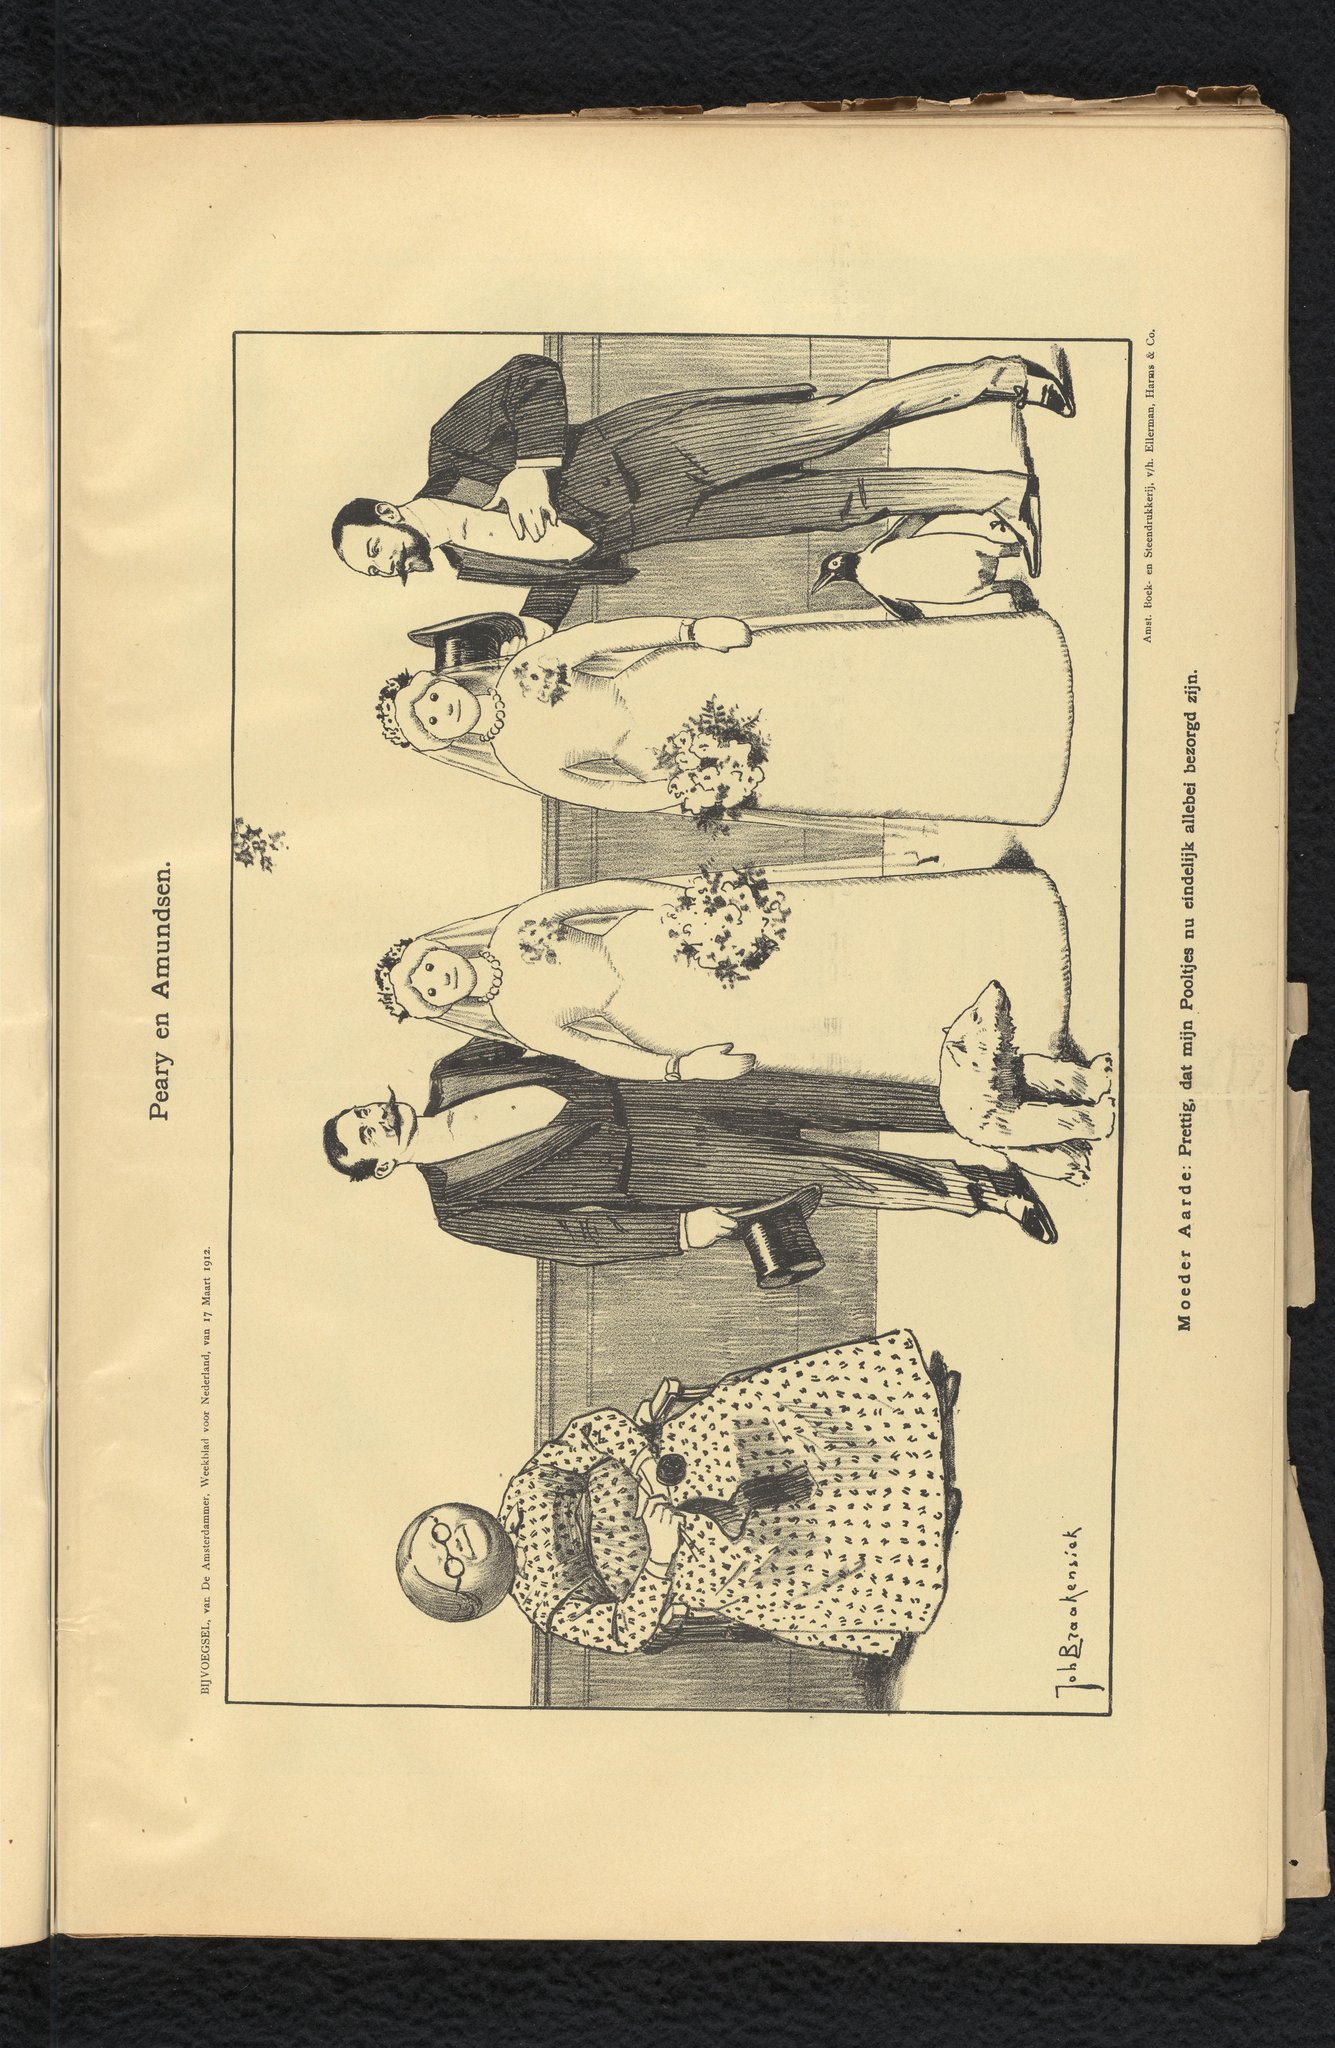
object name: cartoon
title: Peary en Amundsen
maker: johan braakensiek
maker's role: draughtsman, print maker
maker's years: 1858-1940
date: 1912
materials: paper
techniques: lithograph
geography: amsterdam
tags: norway, allegorical representation of the north pole, allegorical representation of the south pole, 'mondo', 'machina del mondo' (ripa), political caricatures and satires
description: Moeder Aarde ziet tevreden hoe naar dochters, de Noordpool (met Peary) en de Zuidpool (met Amundsen), nu allebei aan de man zijn geraakt.